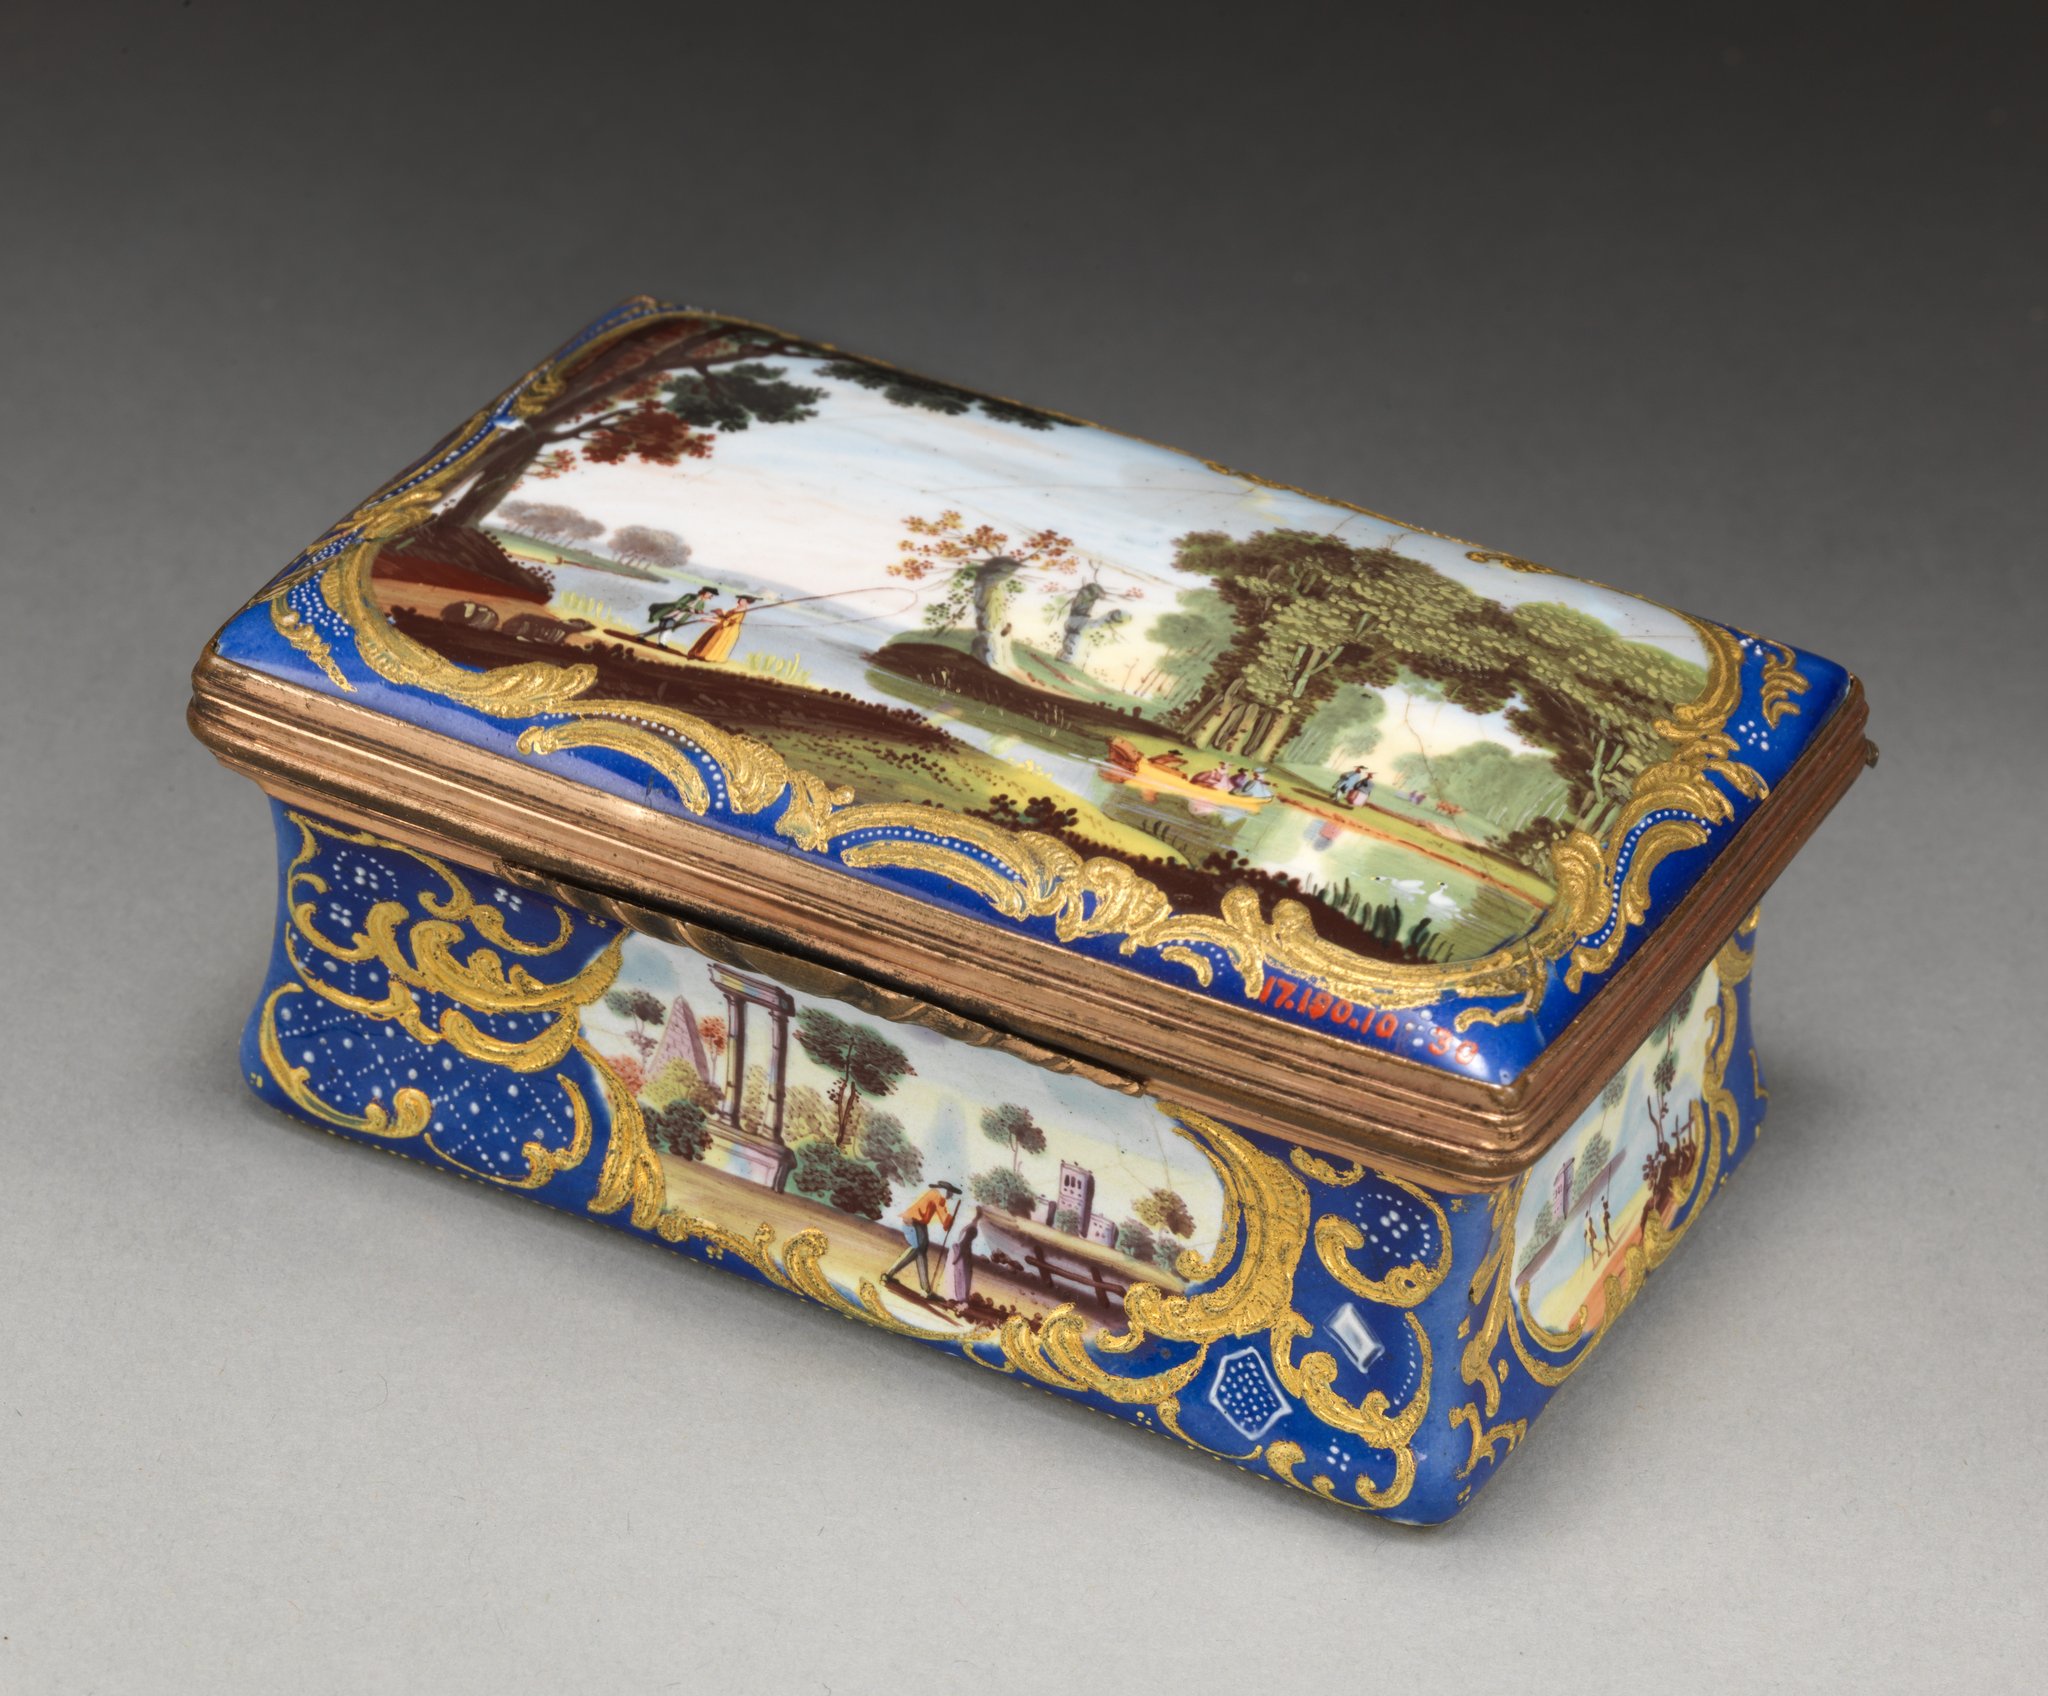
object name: snuffbox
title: Snuffbox with park scene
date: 1765-1770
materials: copper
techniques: enamel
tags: human figures,fishing,landscapes